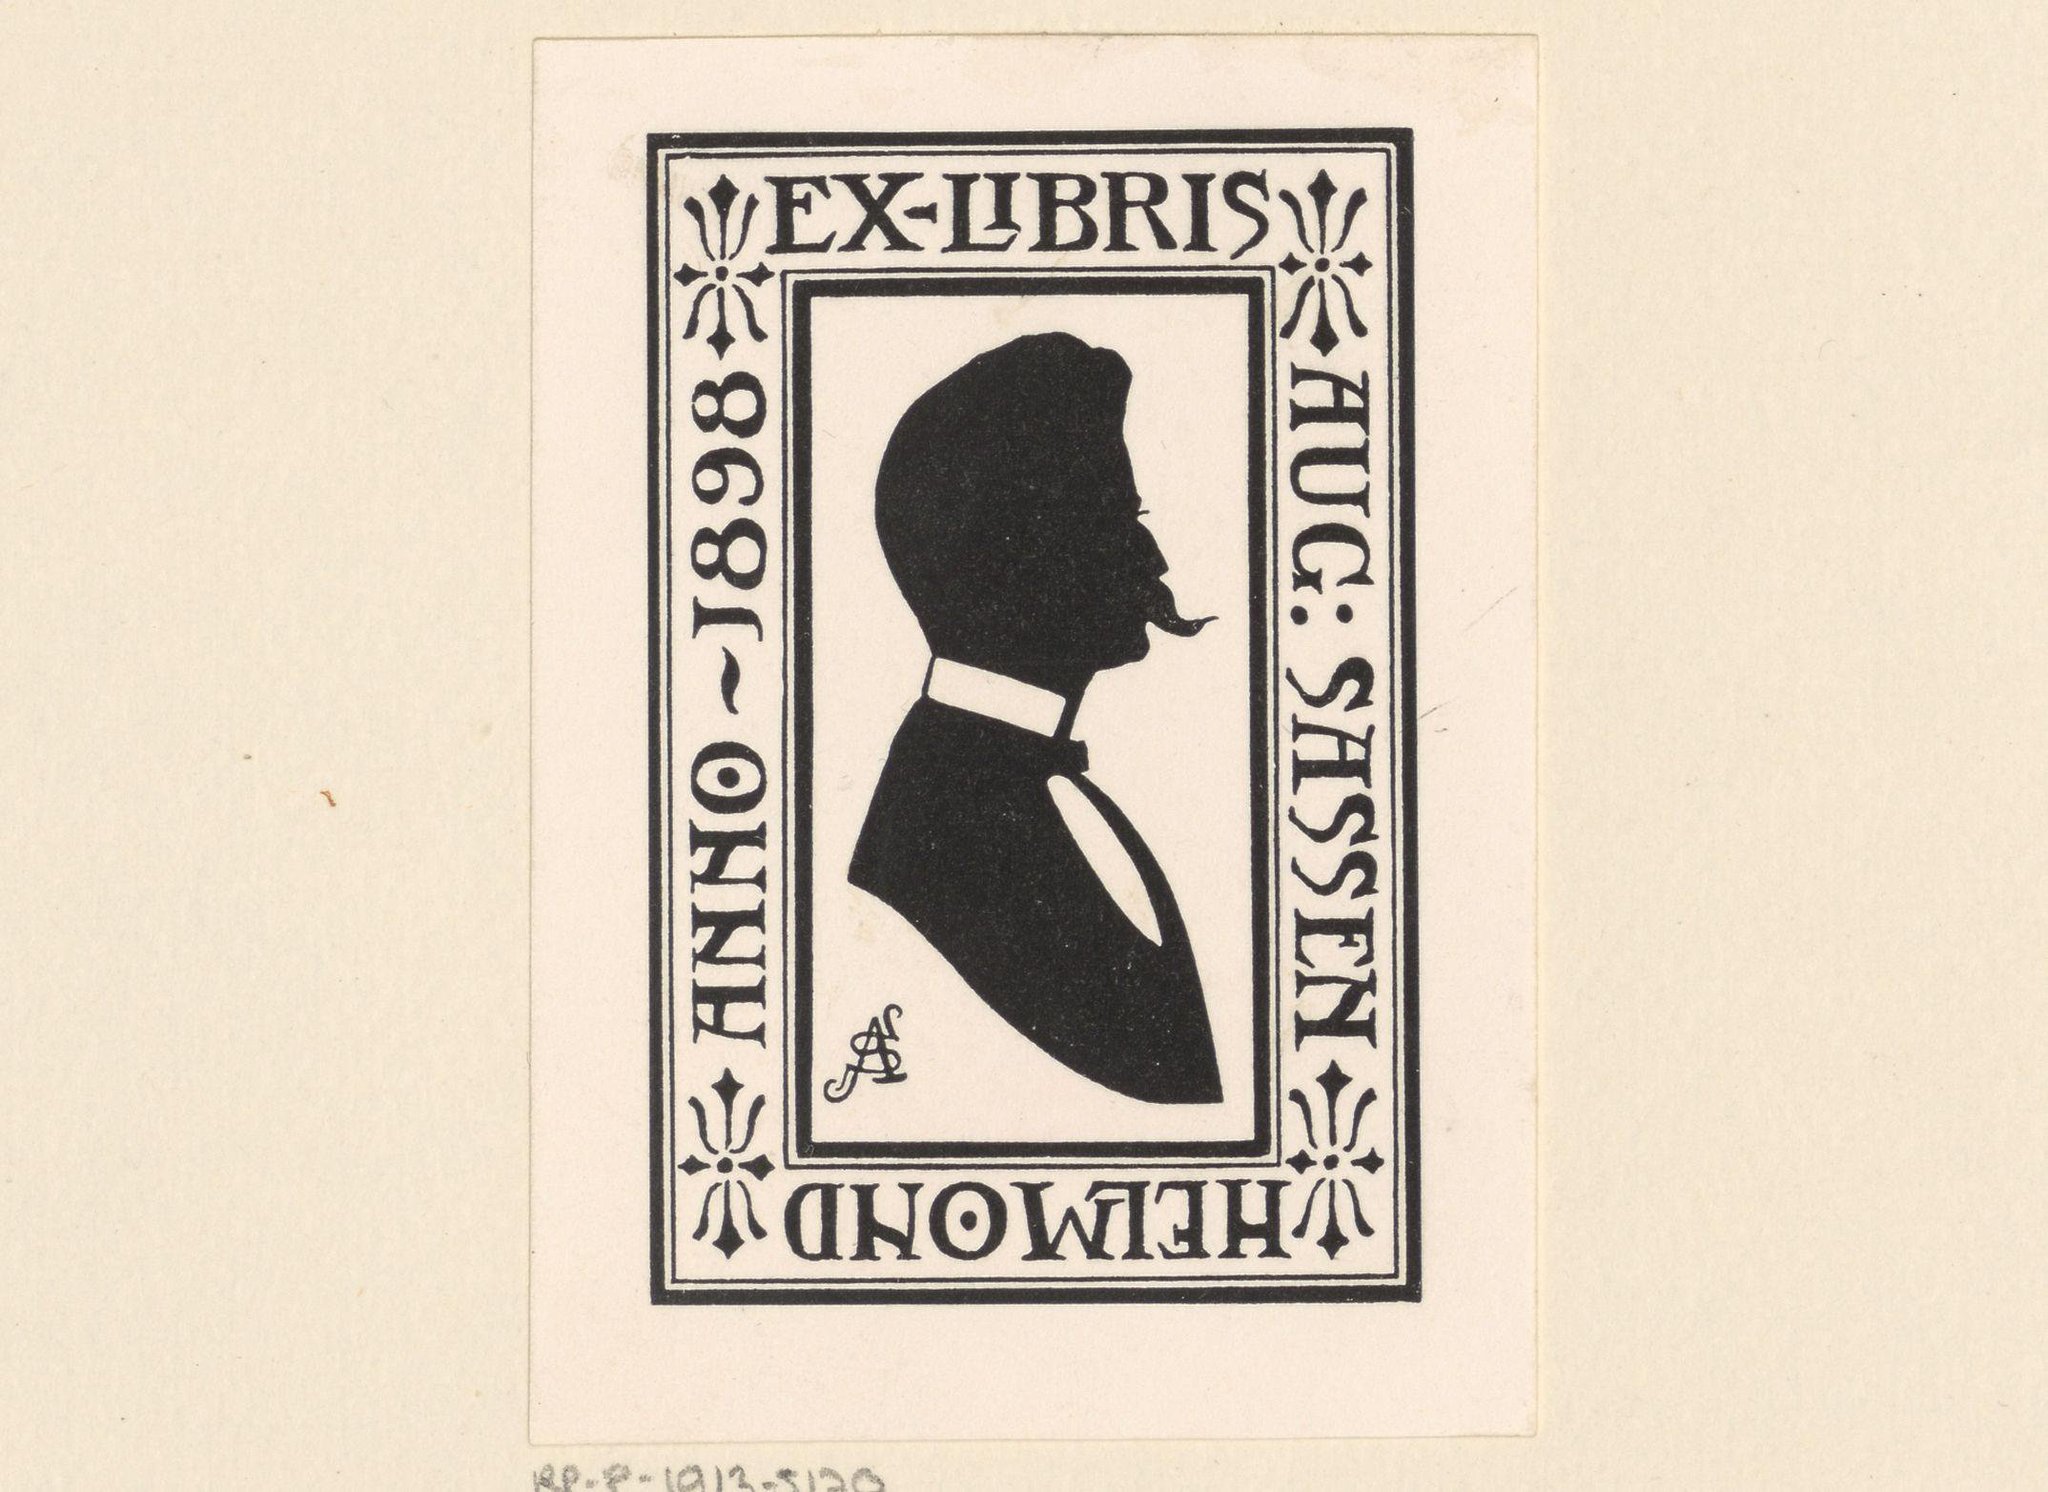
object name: bookplate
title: Ex libris van Aug. Sassen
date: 1898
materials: paper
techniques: printing block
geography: netherlands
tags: den bosch, the hague, print maker, august hendrik sassen, moustache, portrait, self-portrait of artist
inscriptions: collector's mark: Lugt 2760, collector's mark: Lugt 2233